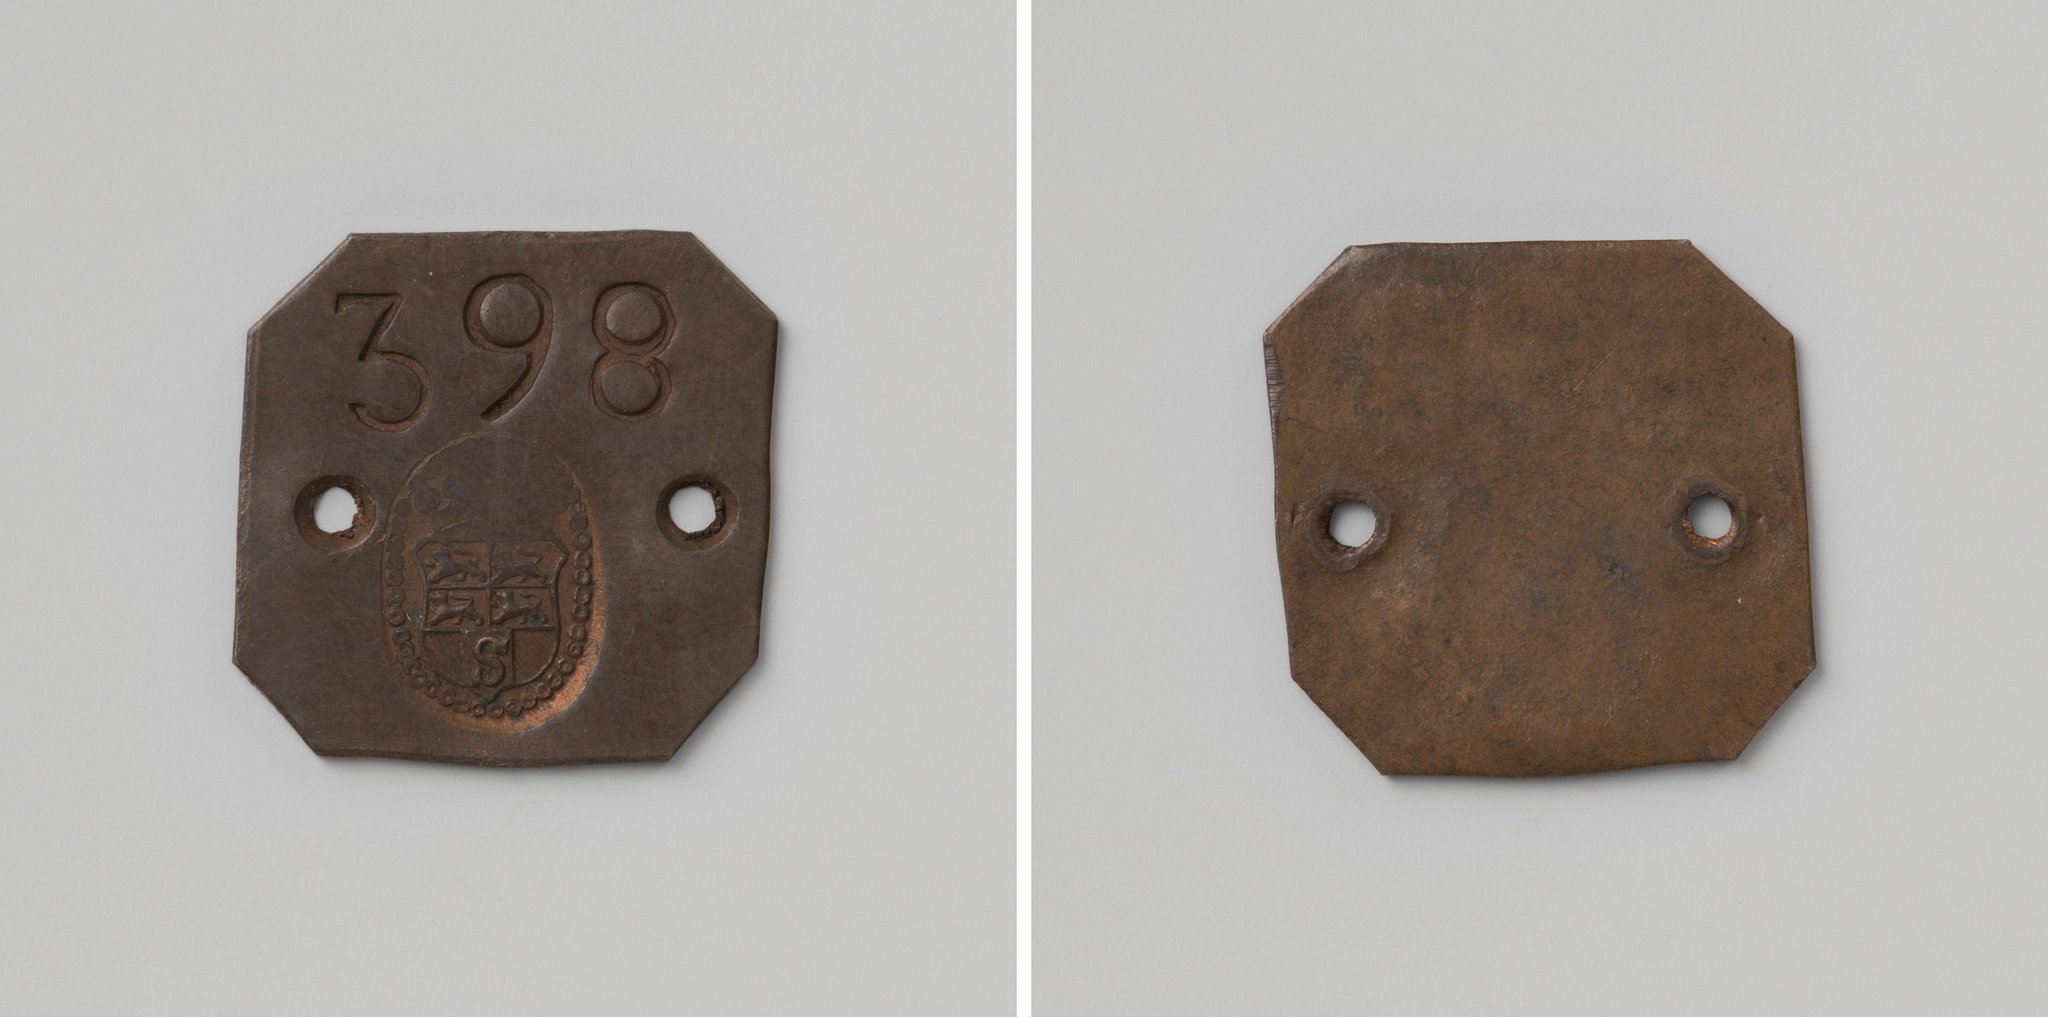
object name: tax token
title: Stad Rotterdam, loodje met no. 398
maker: Anonymous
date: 1800-1875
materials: copper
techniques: striking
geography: rotterdam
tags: rotterdam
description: eenzijdig, vierkant loodje met afgeschuinde hoeken en links en rechts een gat. Voorzijde: wapenschild binnen parelrand onder cijfer 398; op onderste deel van wapenschild: letter S. Keerzijde: blanco